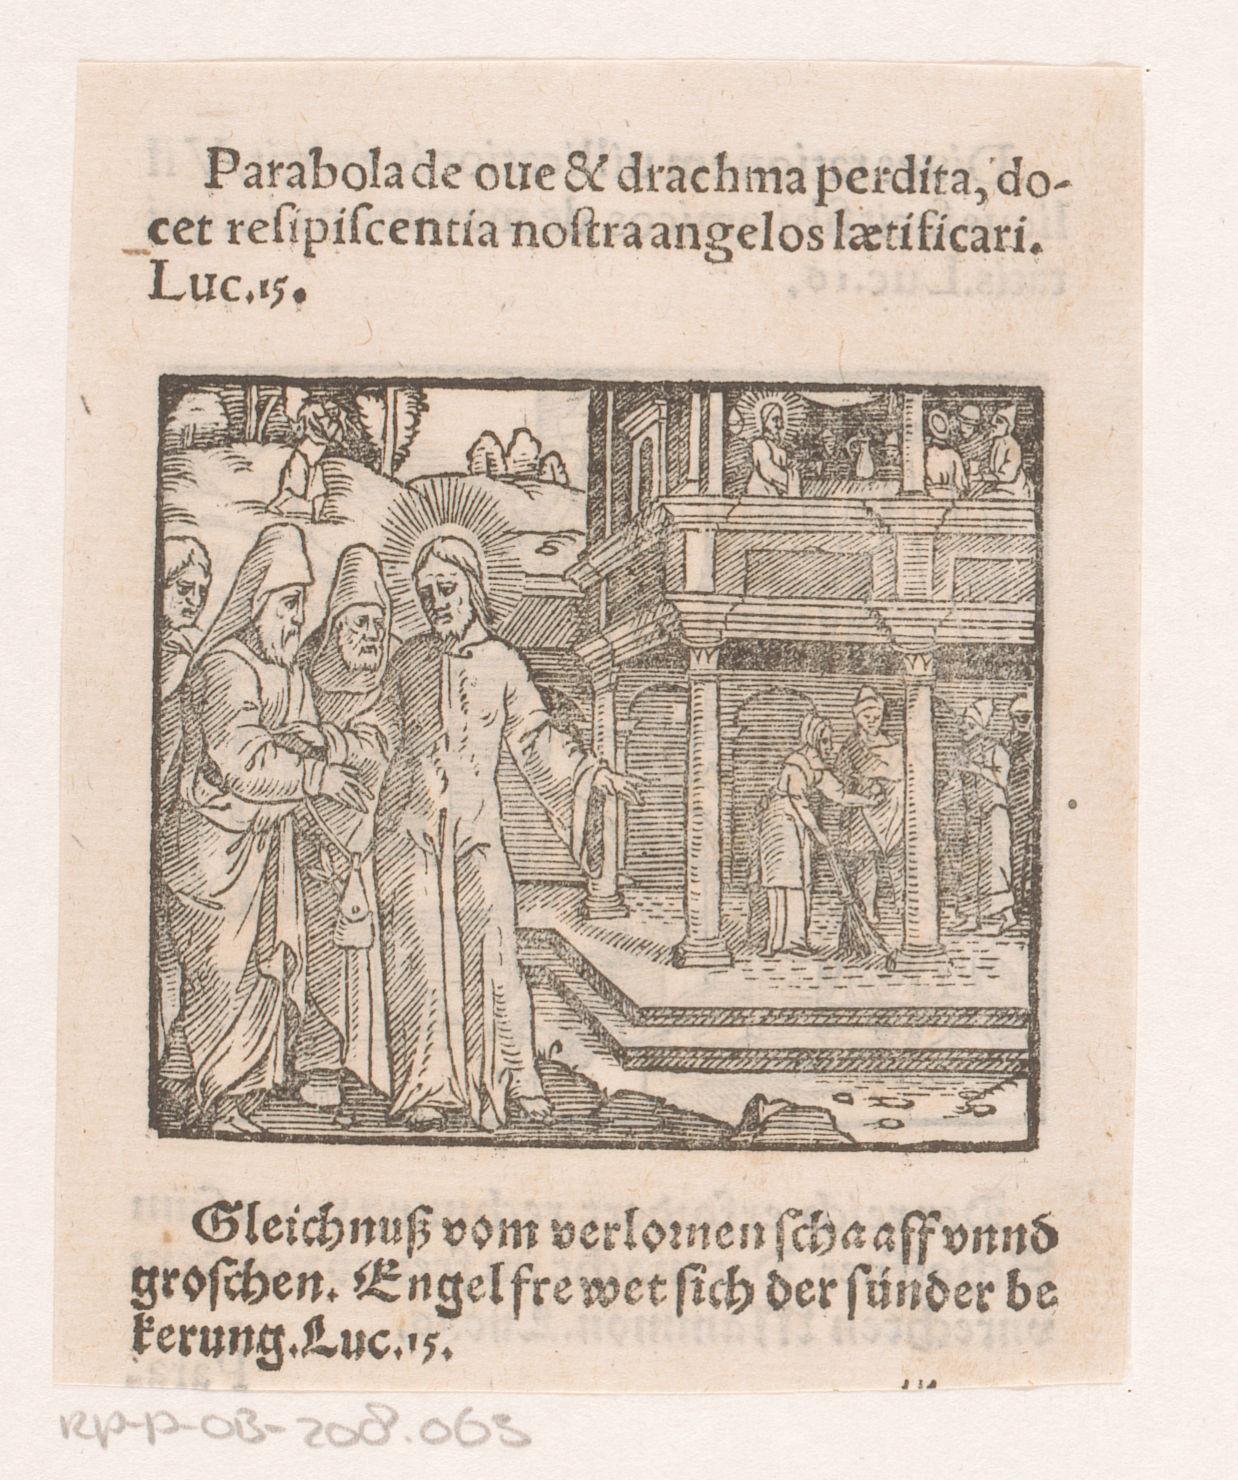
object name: print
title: Gelijkenis van het verloren muntstuk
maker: Anonymous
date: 1600-1699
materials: paper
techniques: letterpress printing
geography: netherlands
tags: the lost piece of silver recovered (luke 15:8-9)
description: Een vrouw met een bezem in de hand vindt haar tiende muntstuk en toont deze.